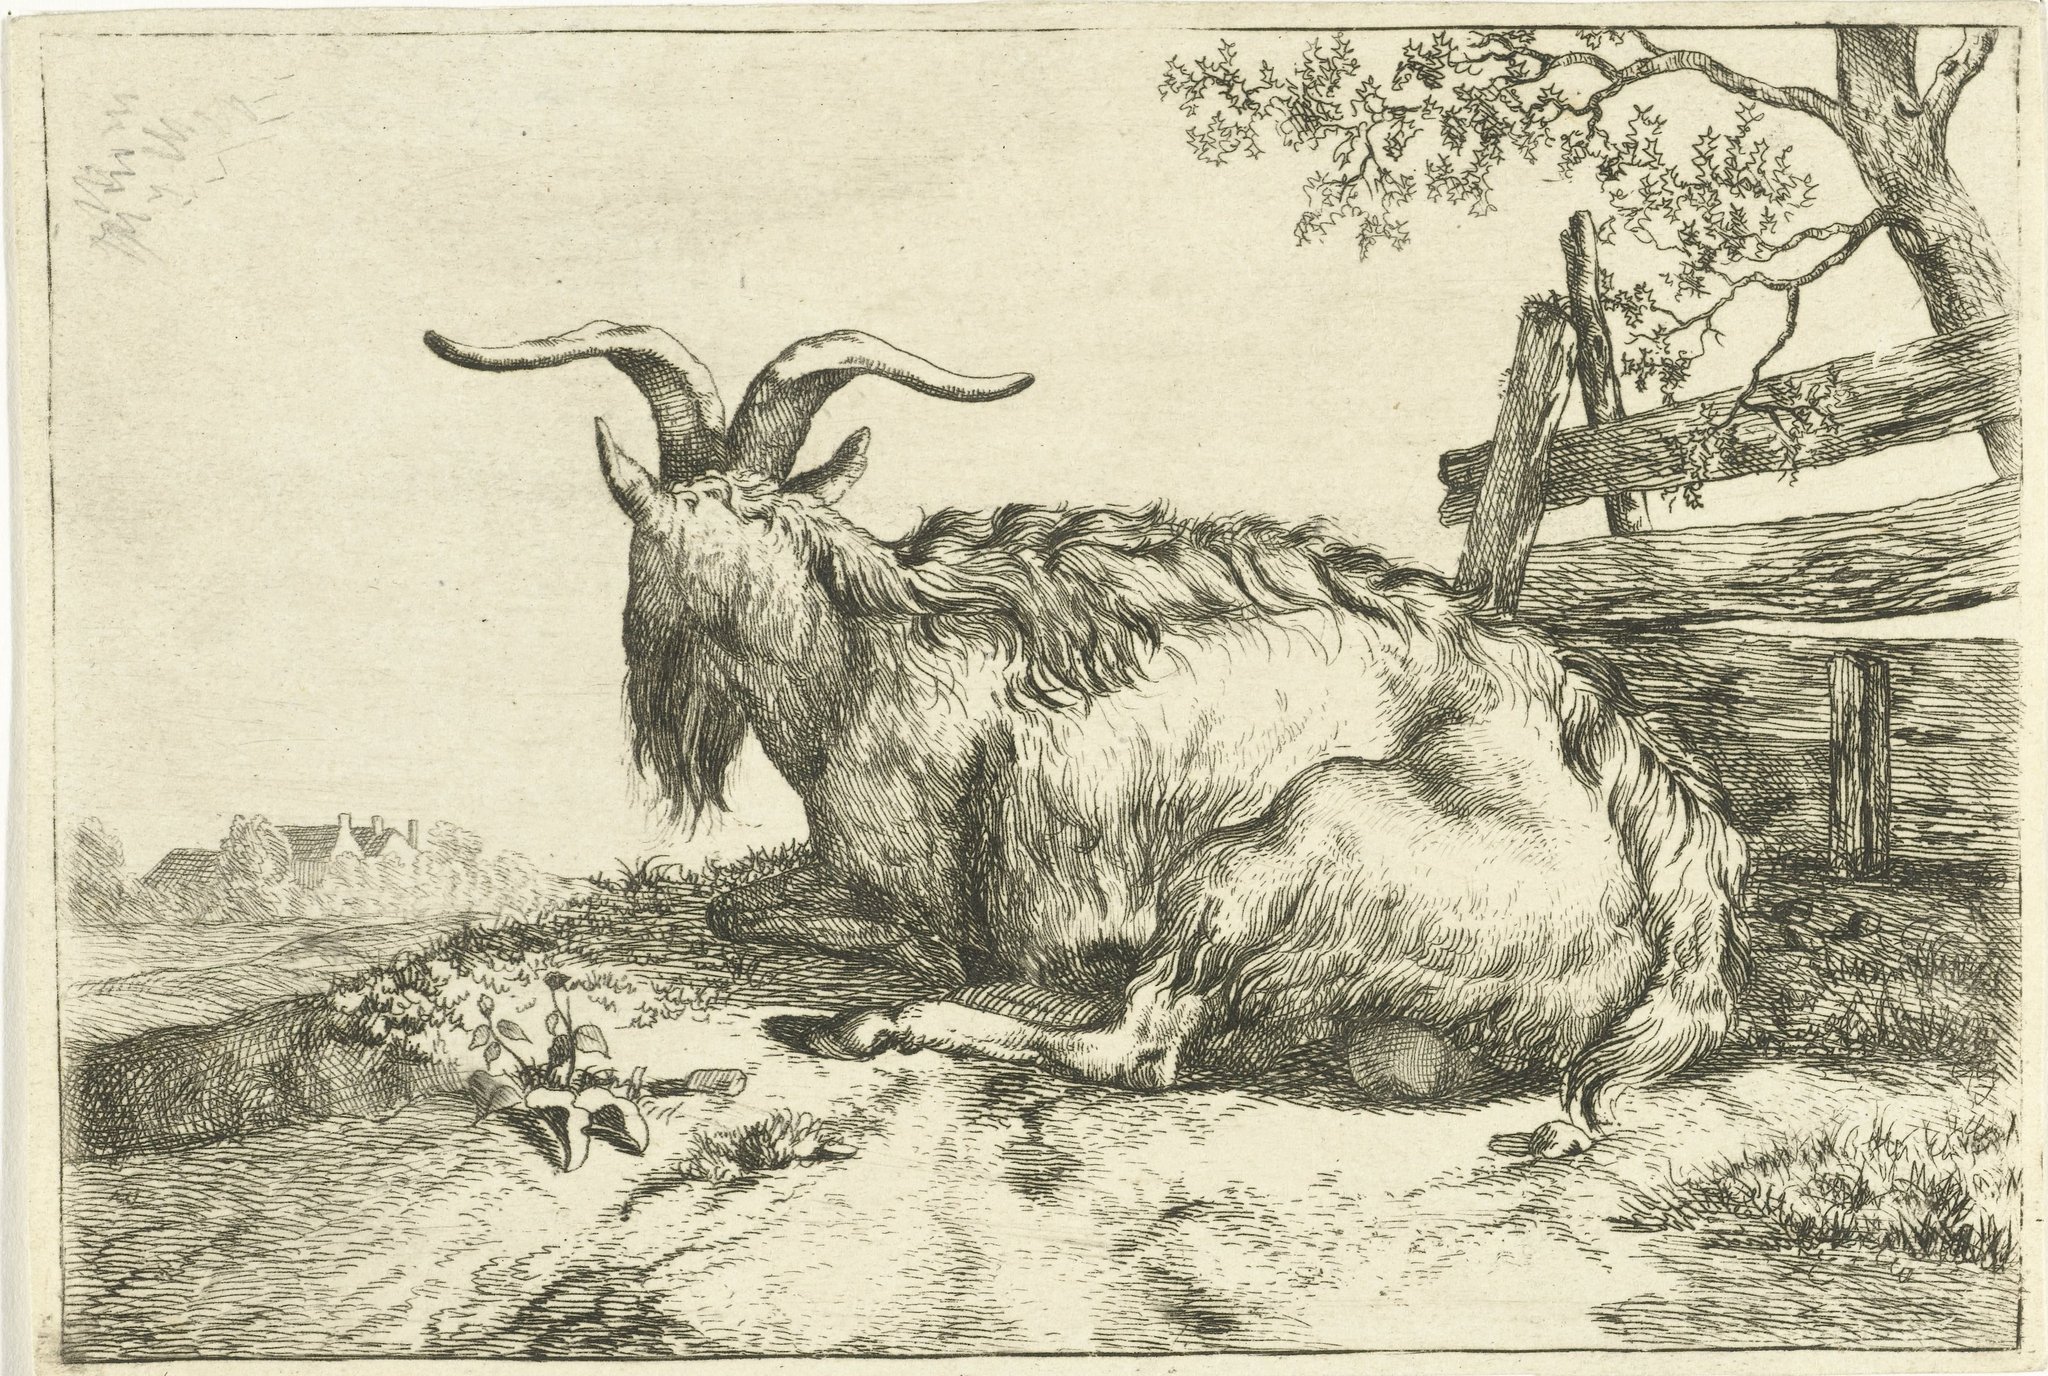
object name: print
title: Liggende geit bij hek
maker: jan dasveldt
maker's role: draughtsman, print maker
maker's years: 1770-1855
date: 1780-1855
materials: paper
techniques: etching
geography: amsterdam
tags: goat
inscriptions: collector's mark: Lugt 2228